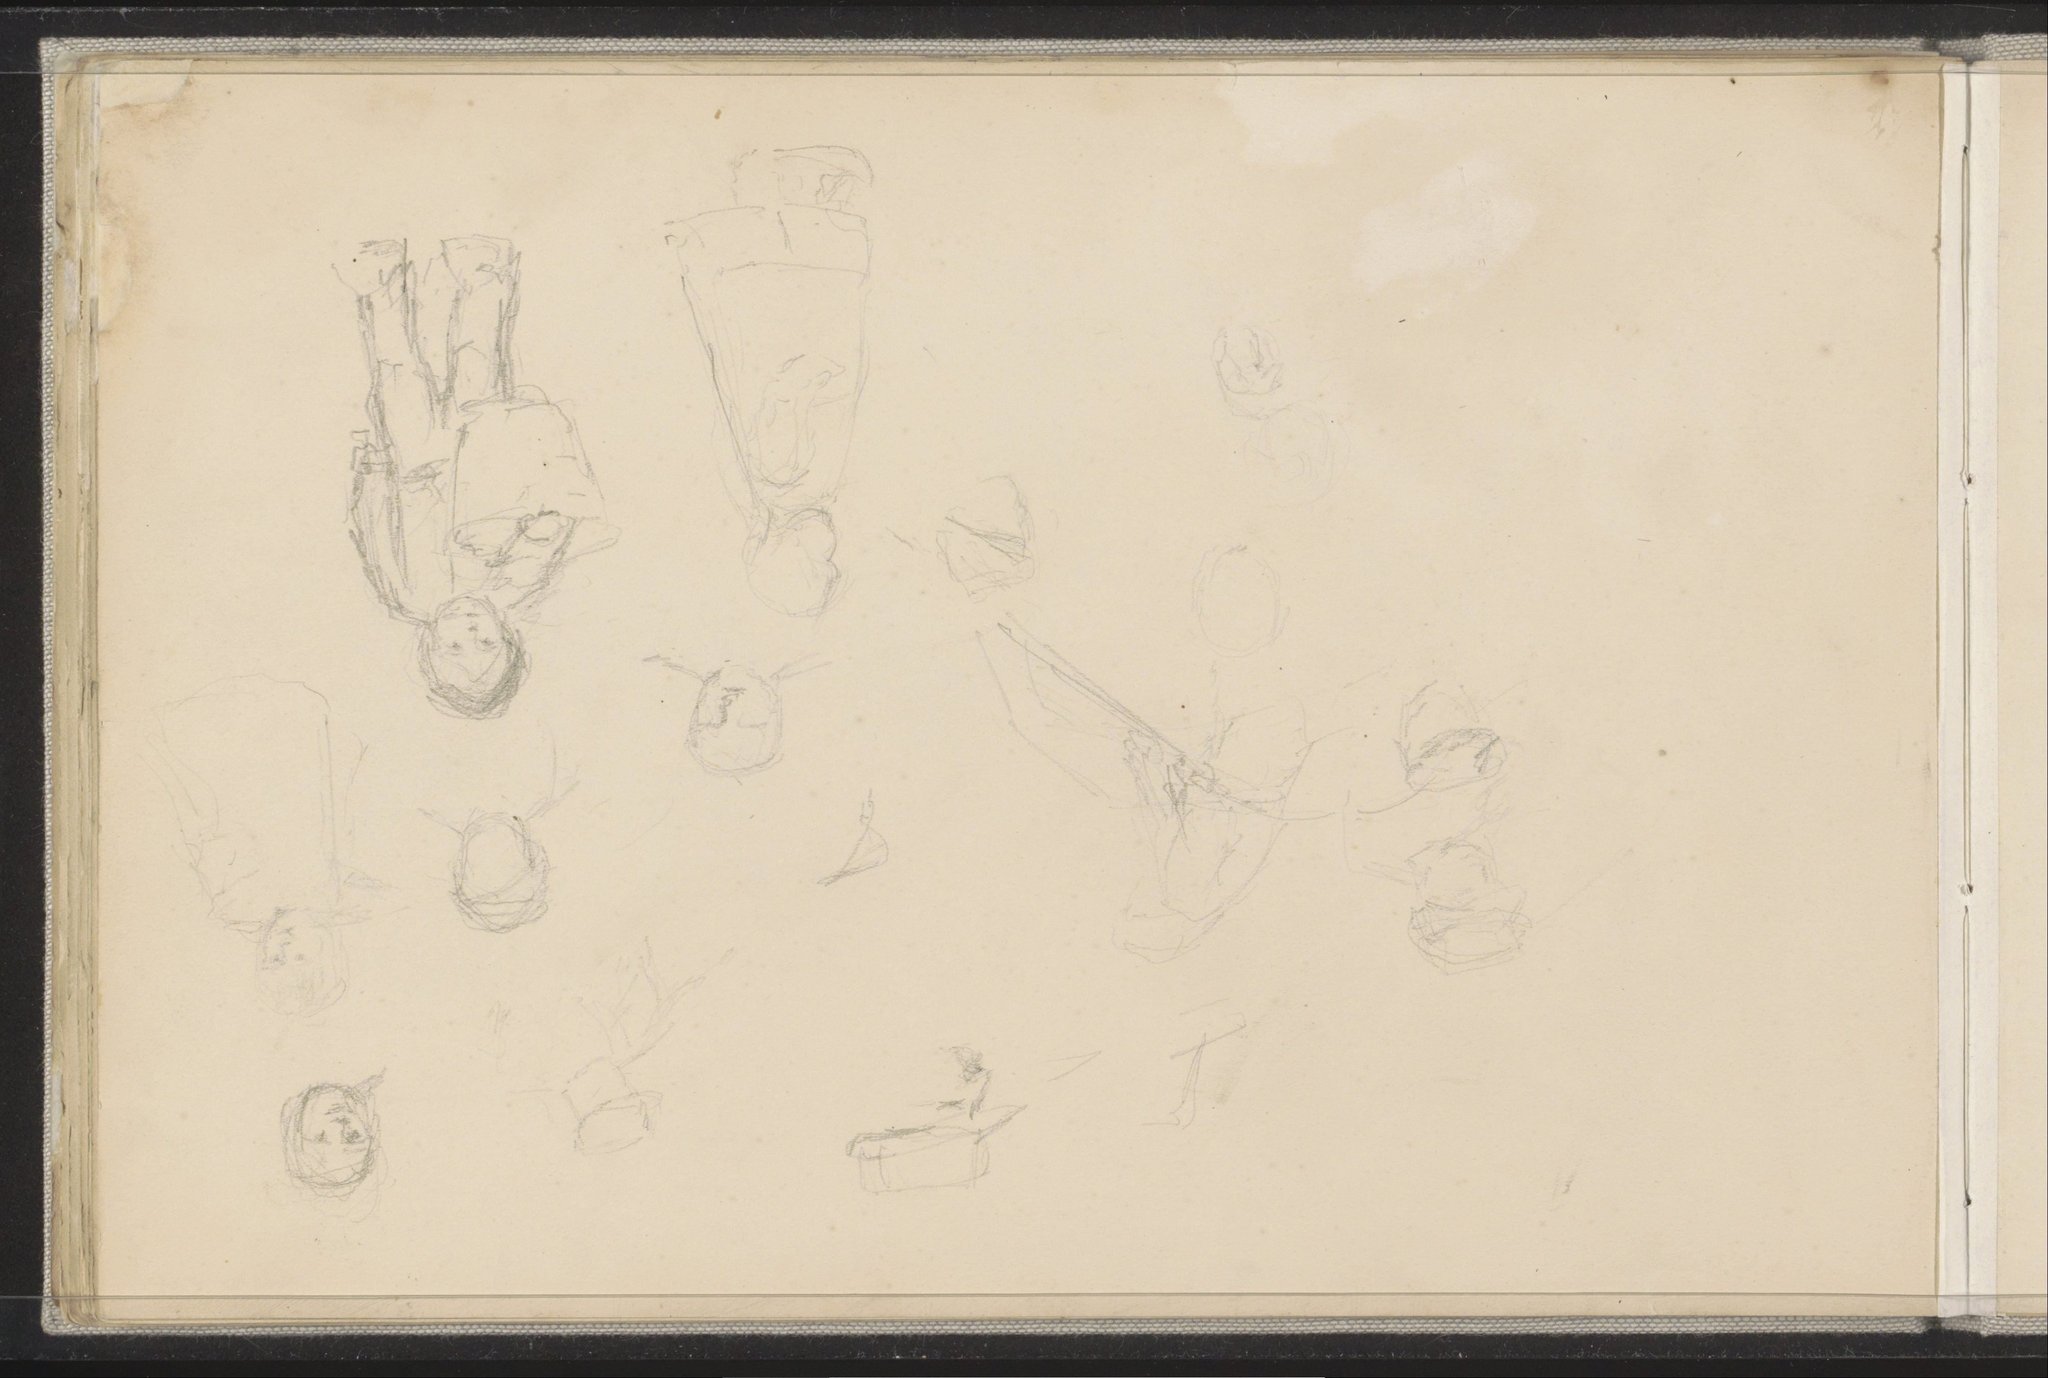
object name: sketchbook leaf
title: Meisje op klompen en een jongen met een mand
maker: jozef israëls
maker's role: draughtsman, painter, print maker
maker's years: 1824-1911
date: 1834-1911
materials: paper, pencil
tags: head (human), boy (child between toddler and youth), container made of plant material other than wood: basket, girl (child between toddler and youth)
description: Tevens koppen van mannen, vrouwen en kinderen. Blad 28 verso uit een schetsboek met 30 bladen.